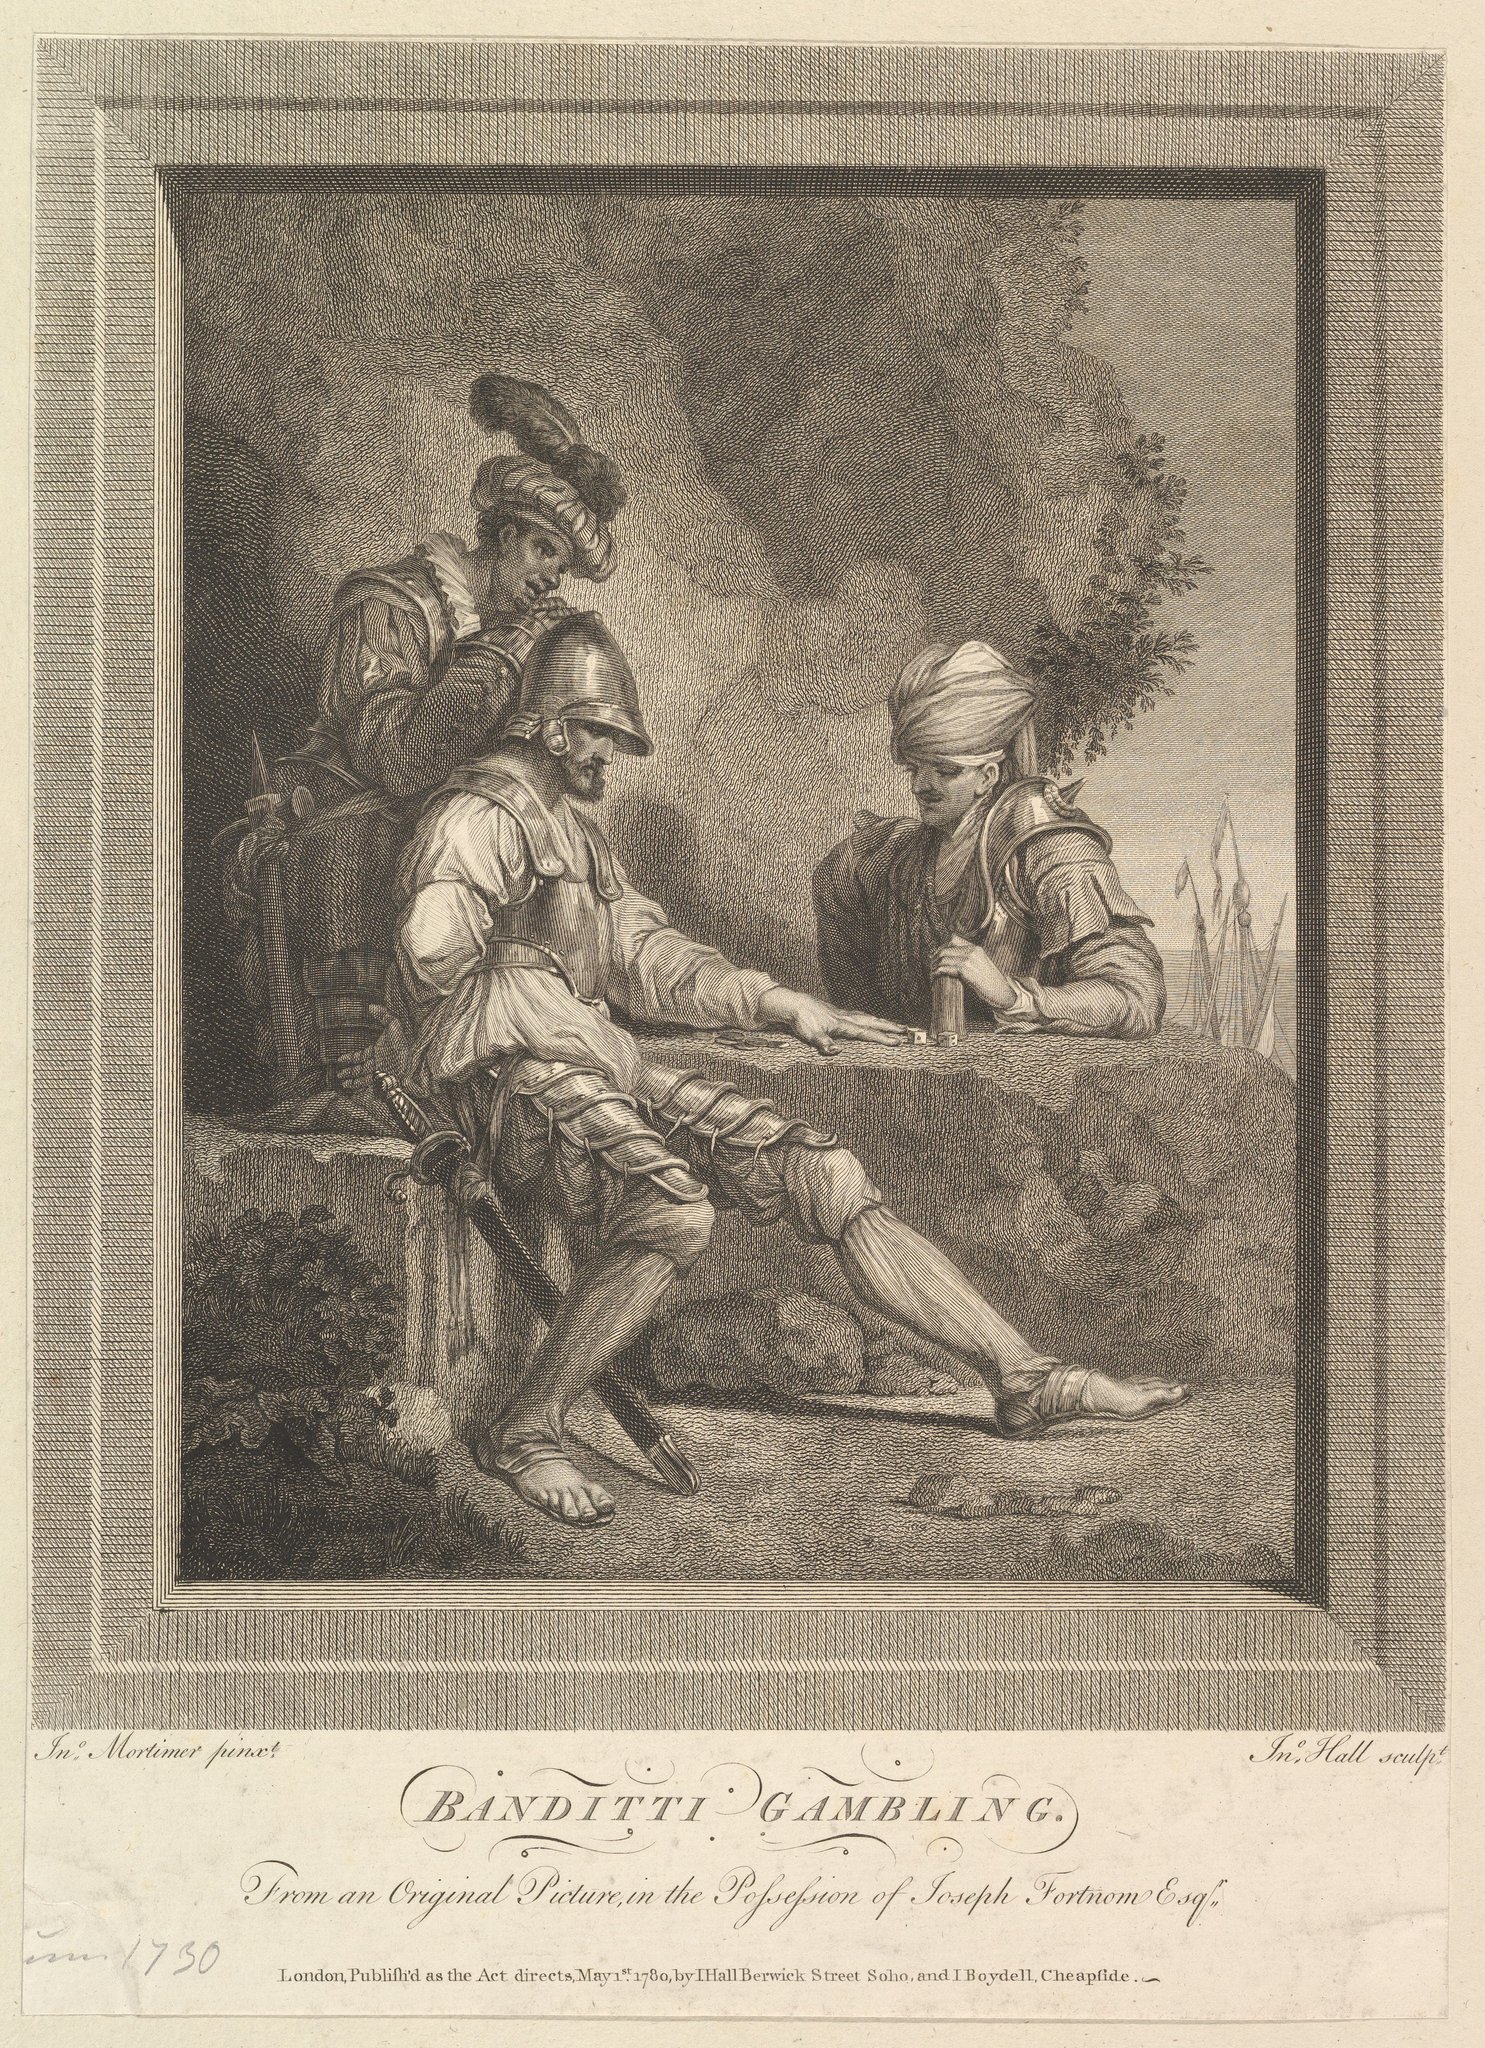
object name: print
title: Banditti Gambling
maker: john hall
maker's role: artist and engraver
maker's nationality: british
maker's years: 1739-1797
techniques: engraving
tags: soldiers,weapons,men,gambling